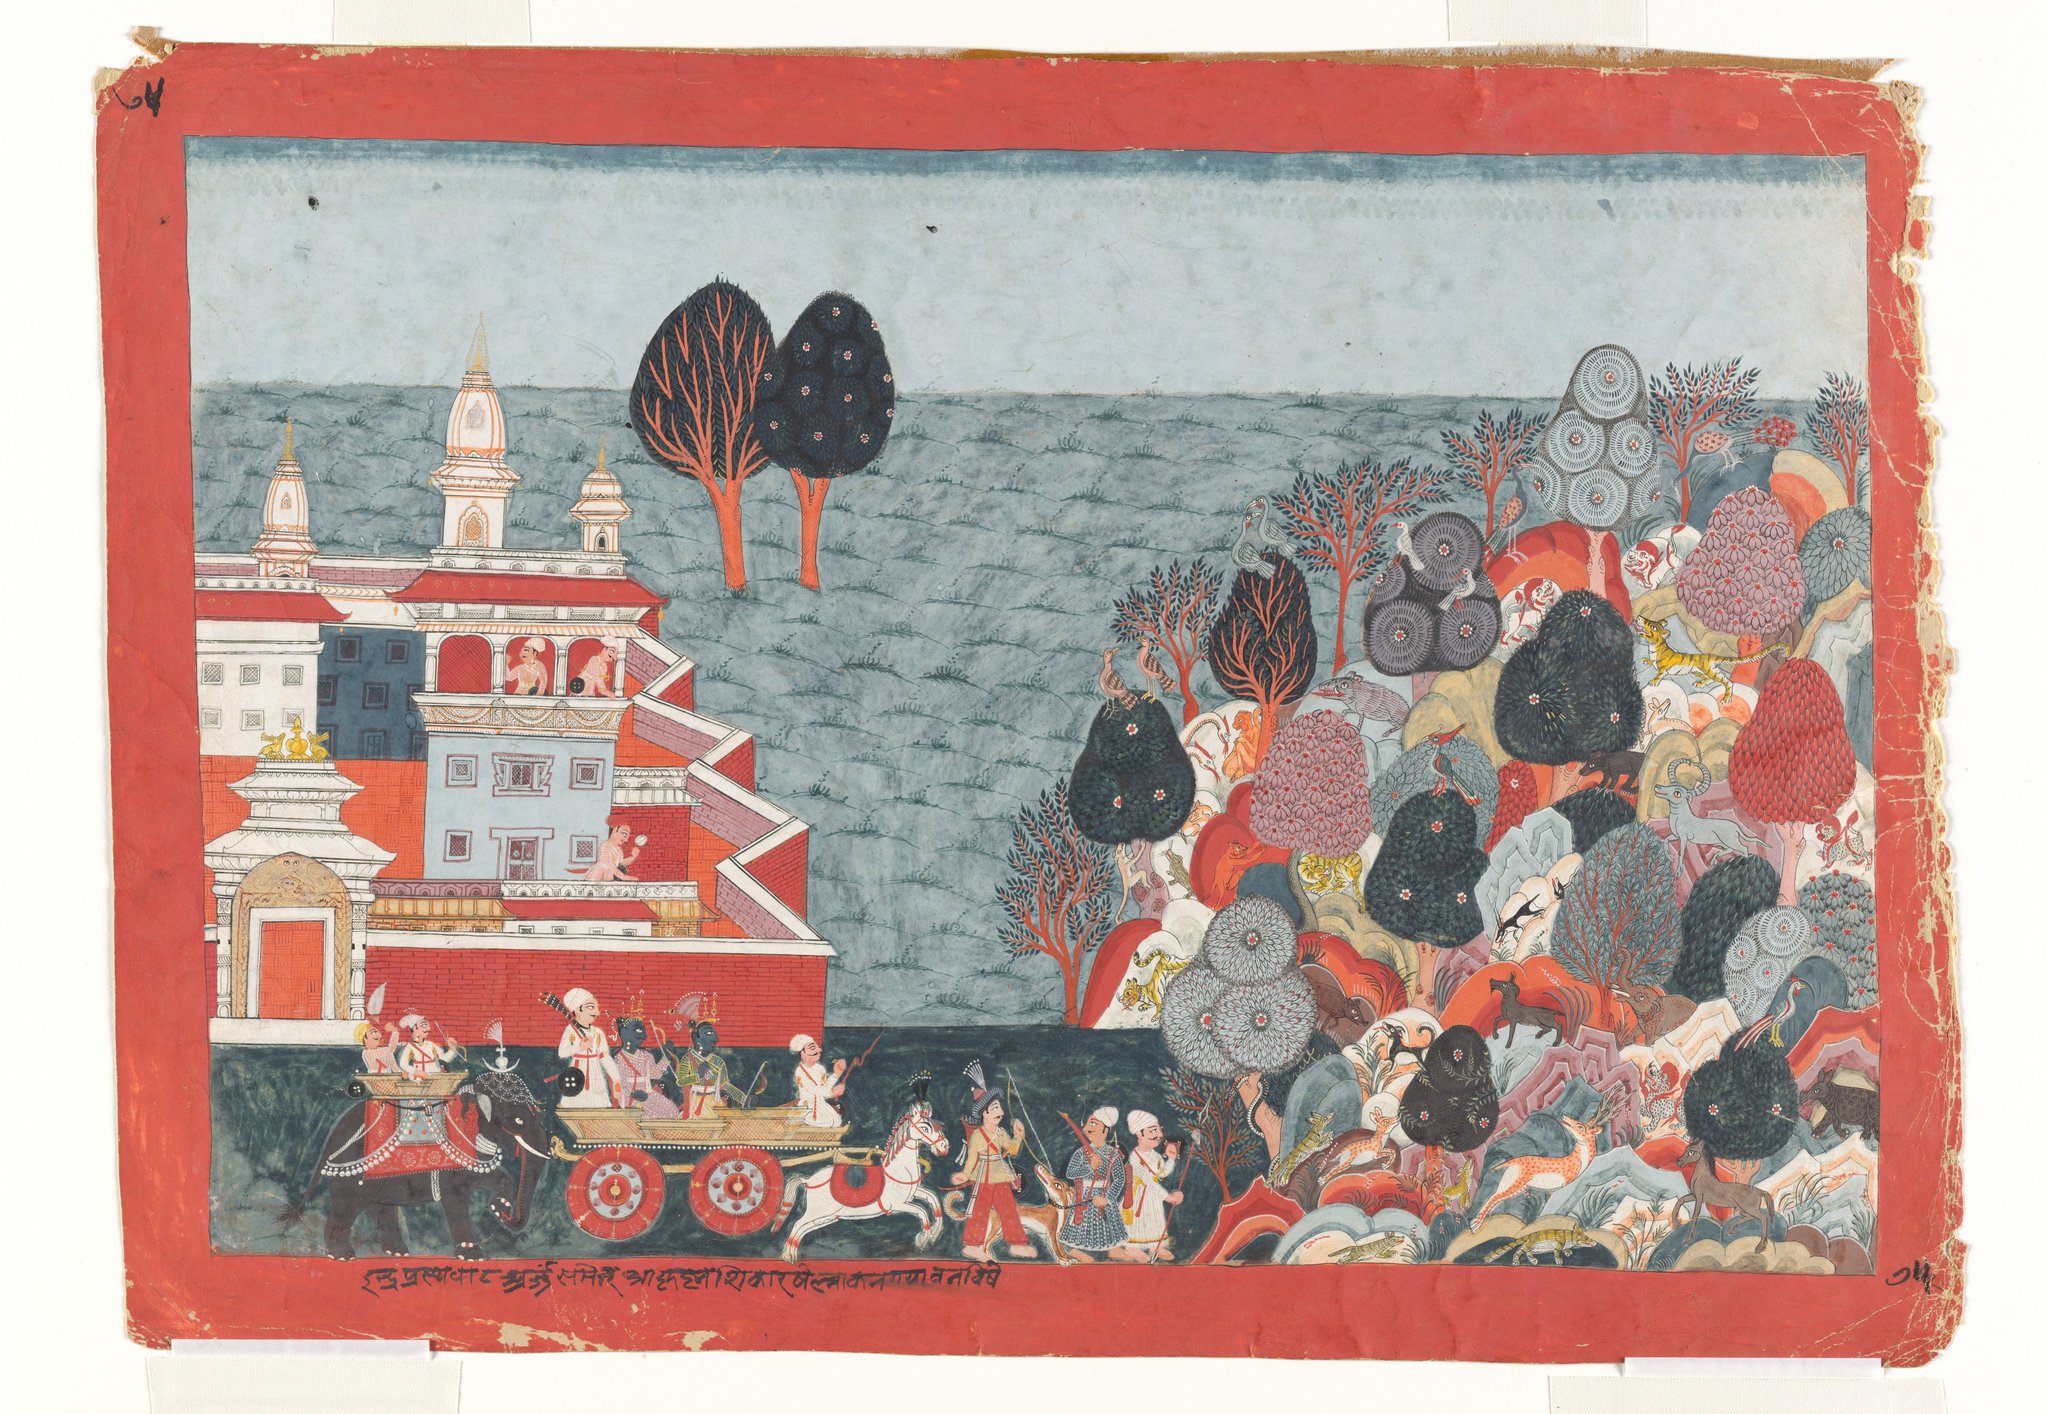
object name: folio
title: Folio from a Bhagavata Purana series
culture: nepali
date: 1775-1800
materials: ink, paper, watercolor